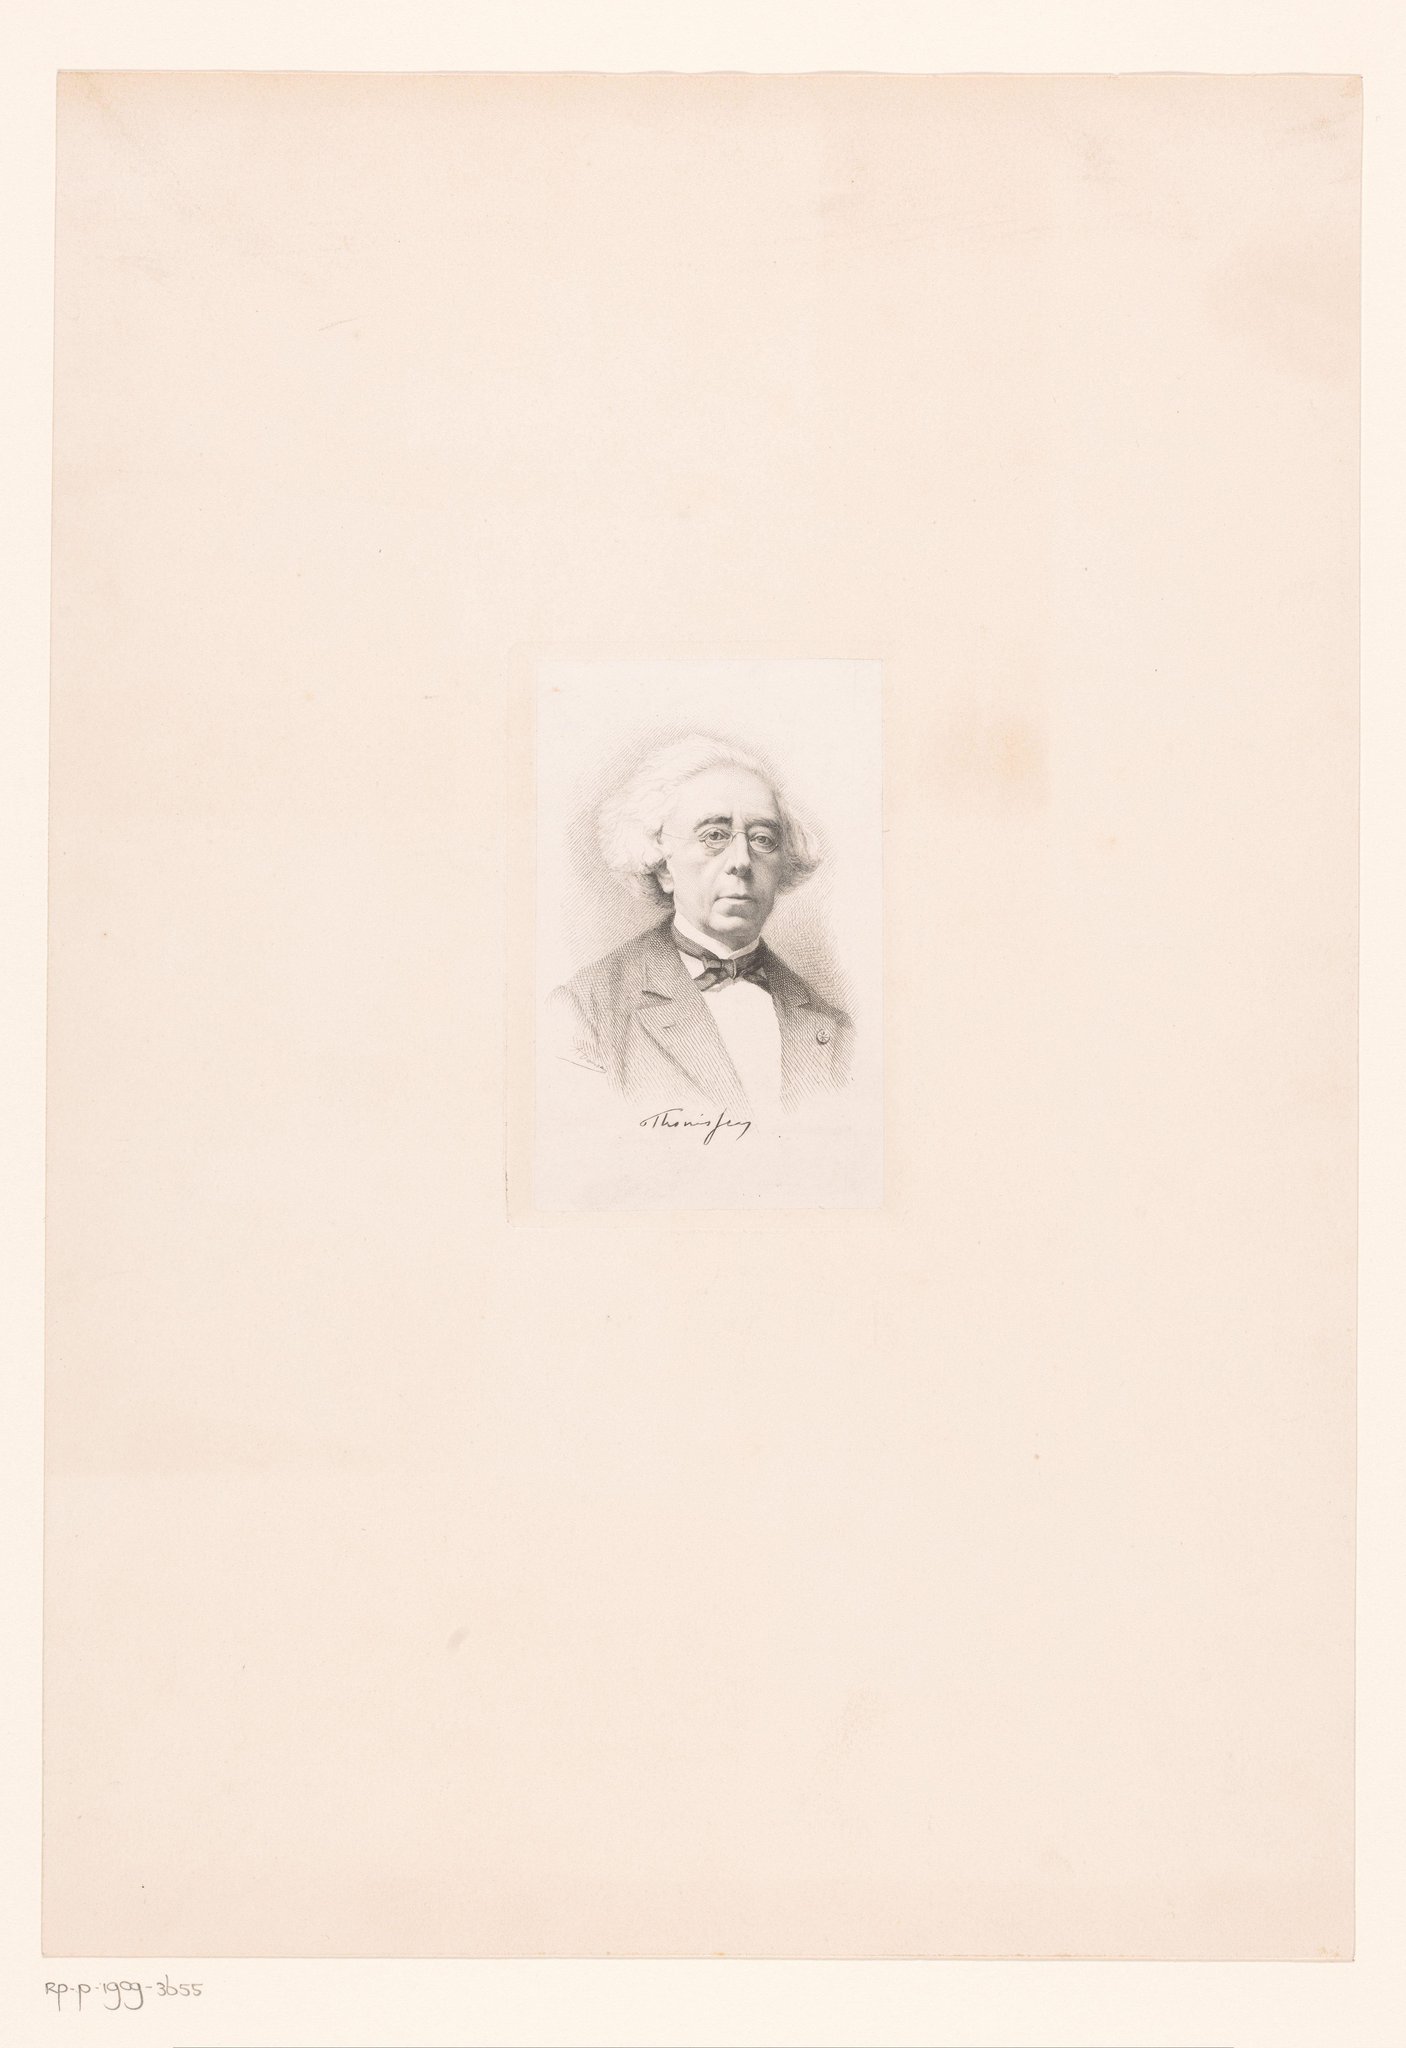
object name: print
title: Portret van Jean Joseph Thonissen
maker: auguste danse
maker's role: print maker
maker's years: 1829-1929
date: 1839-1909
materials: paper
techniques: etching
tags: jean-joseph thonissen, historical person (...) - historical person (...) portrayed alone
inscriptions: collector's mark: Lugt 2228